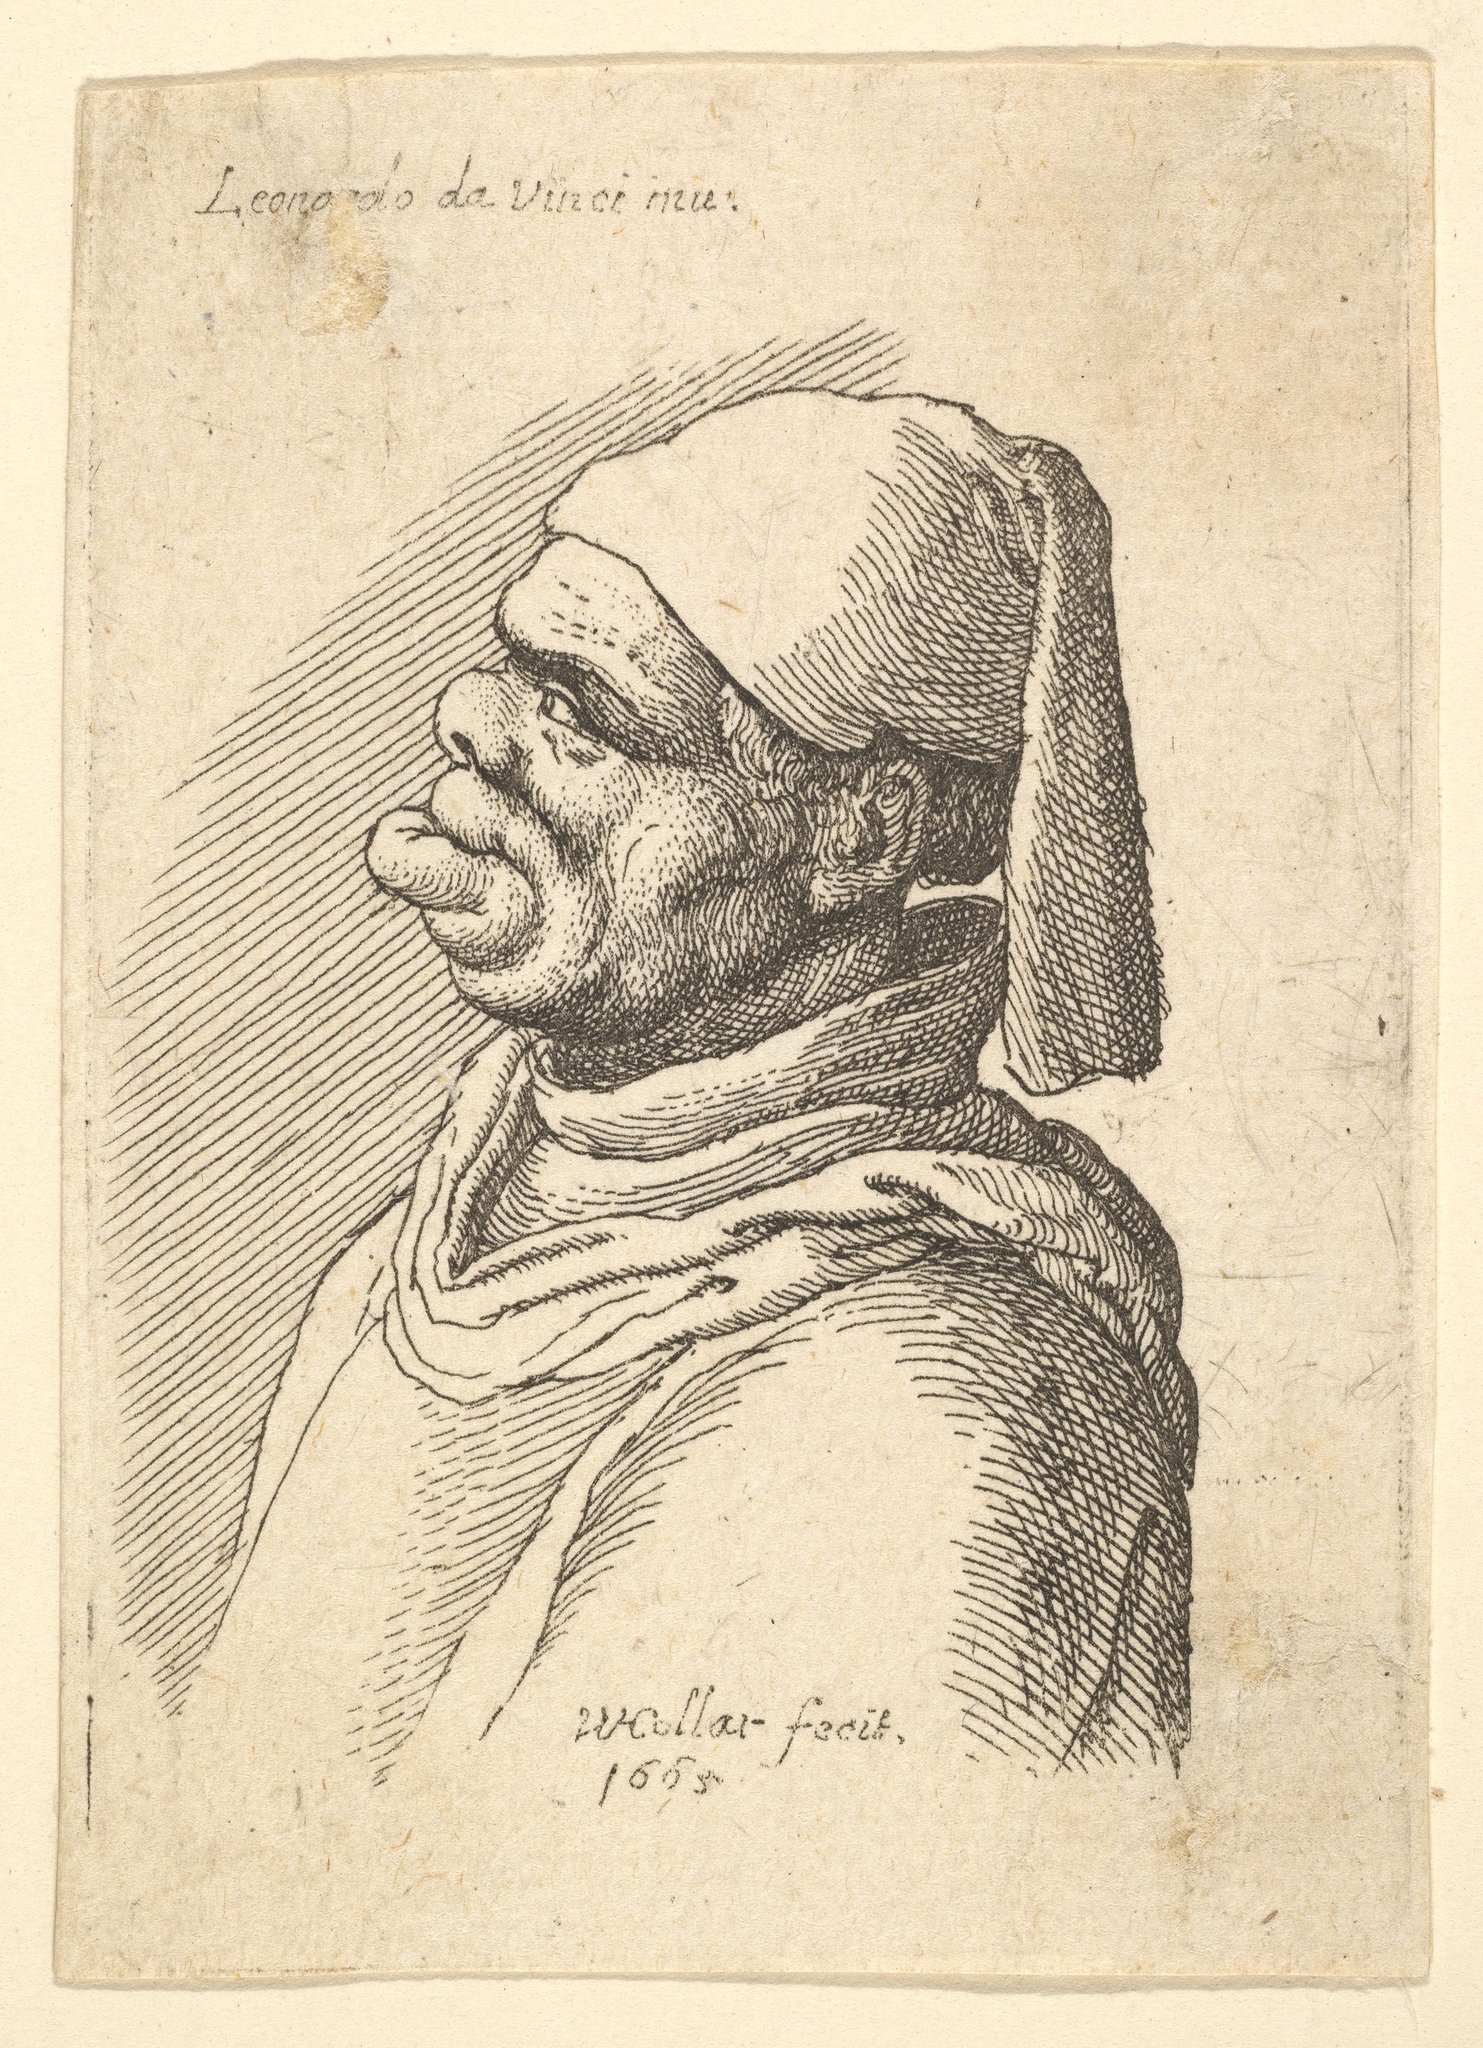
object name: print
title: Bust of a deformed man with a hat and a fat, protruding lower lip in profile to left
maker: wenceslaus hollar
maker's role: artist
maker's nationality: bohemian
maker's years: 1607-1677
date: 1665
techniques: etching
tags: men